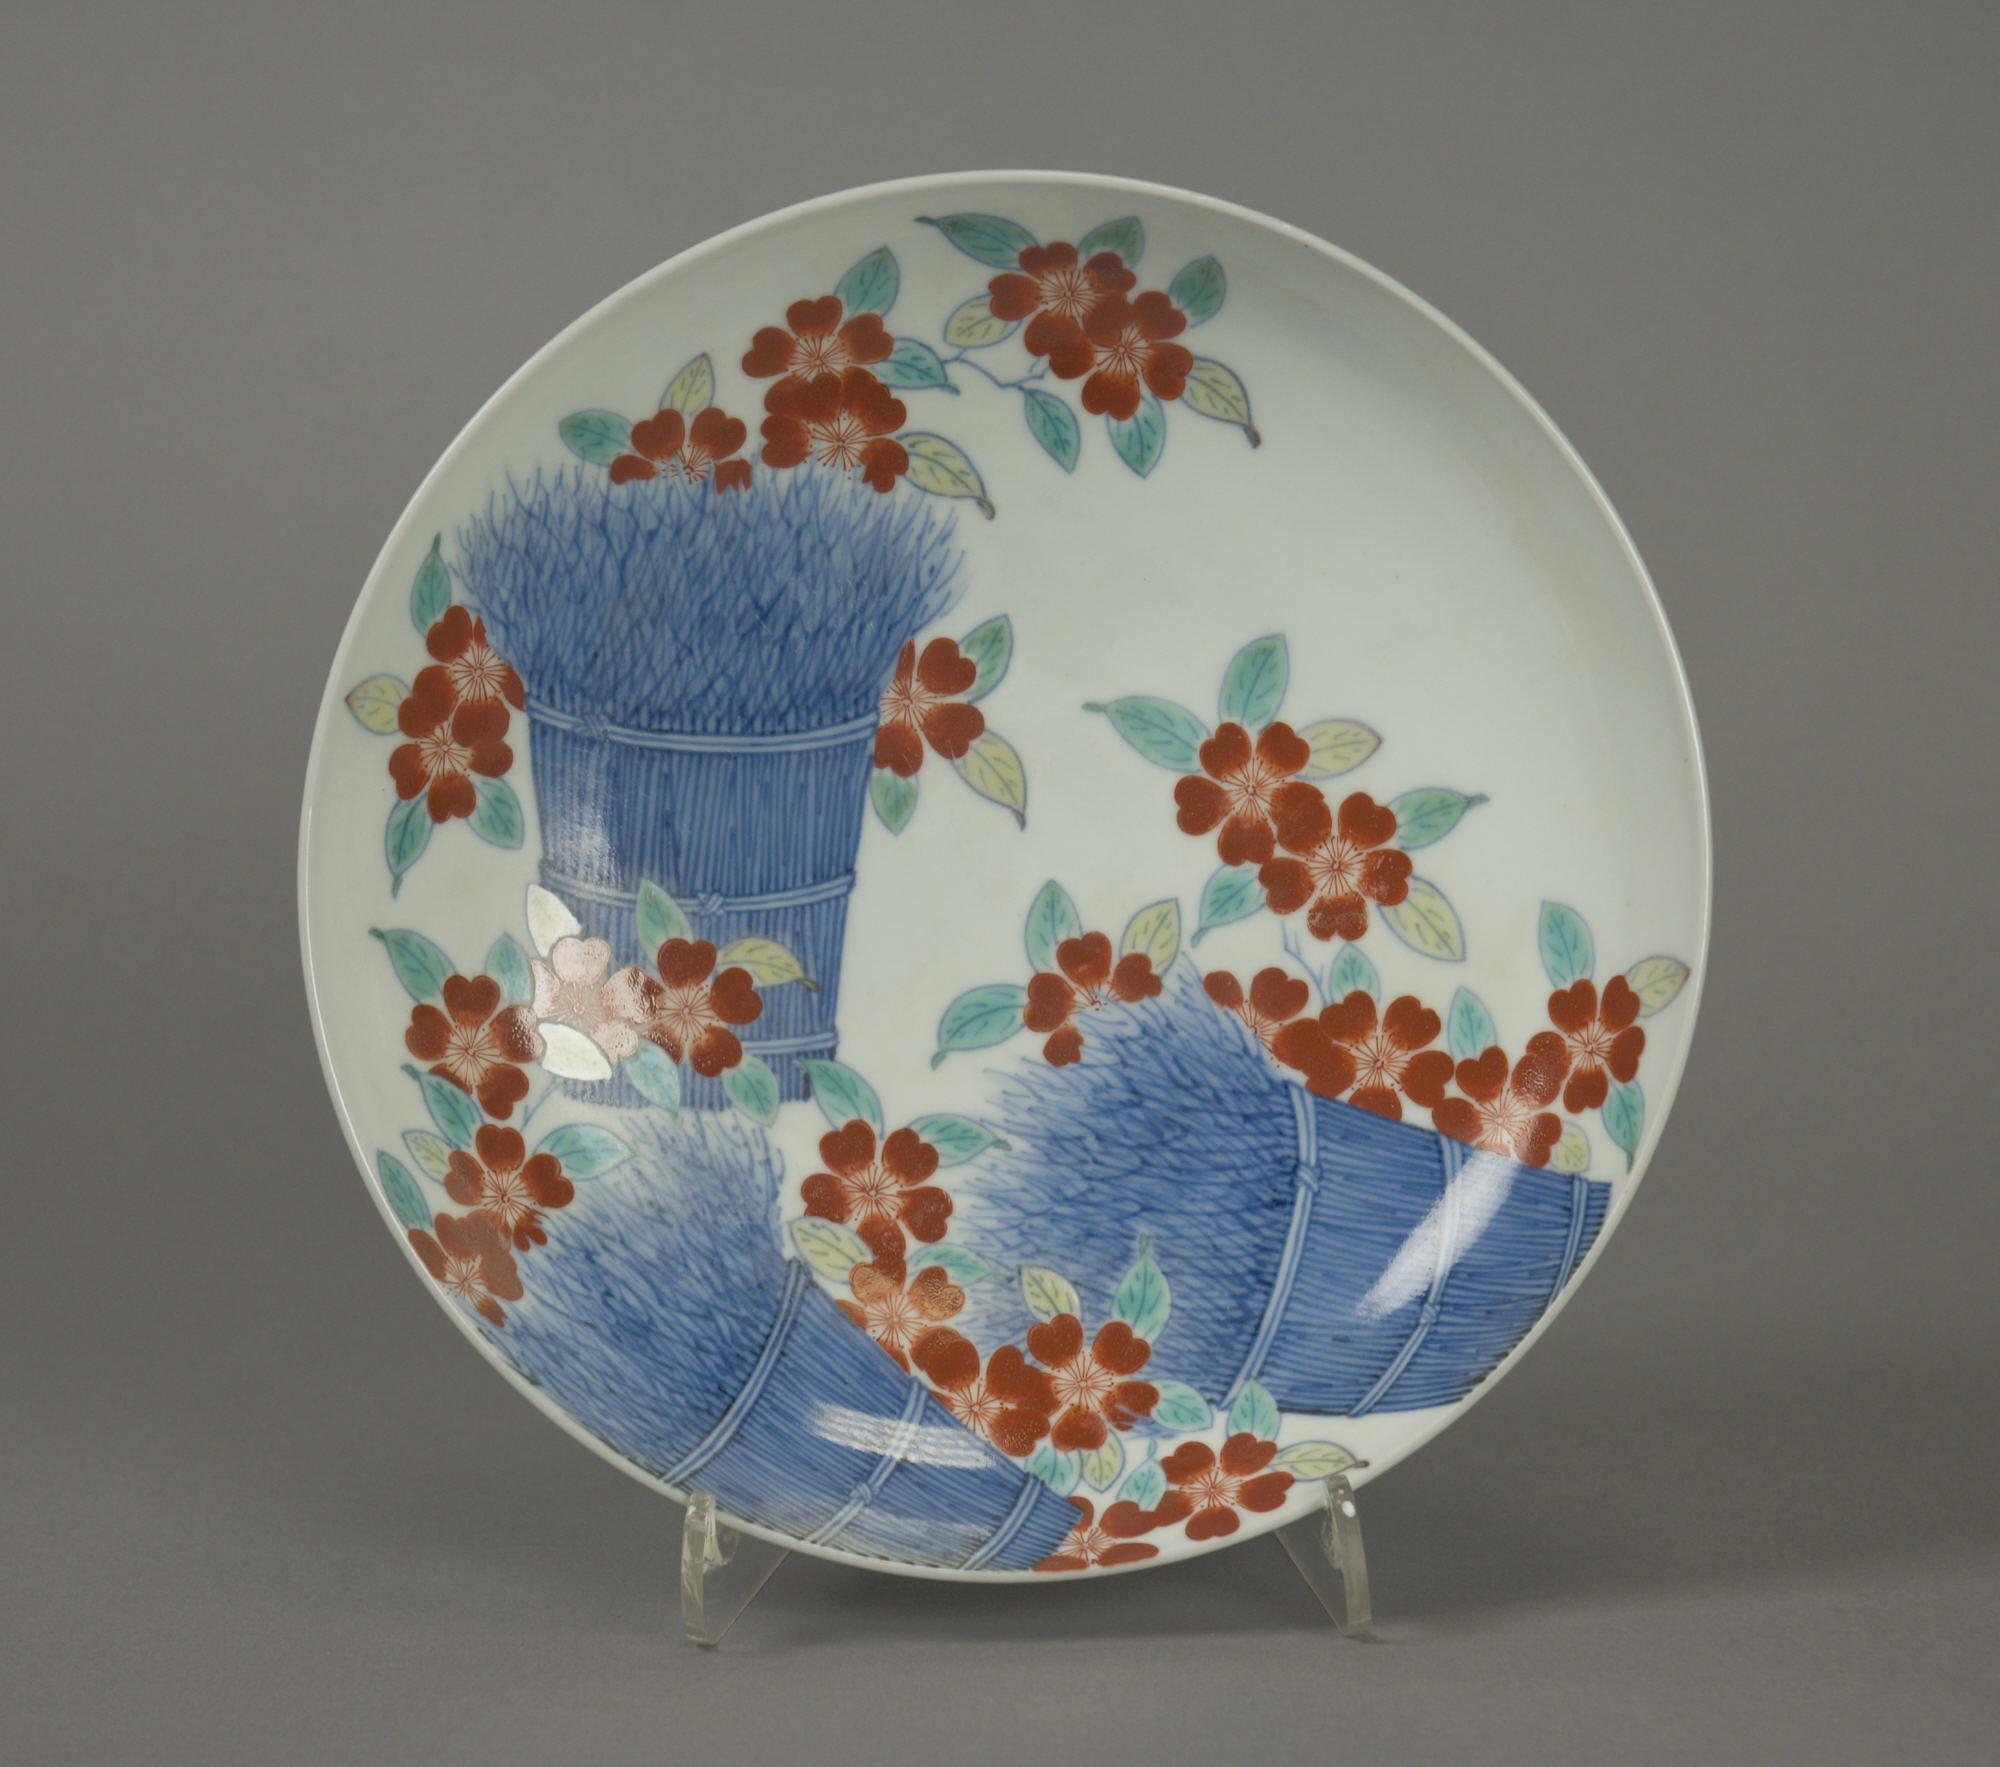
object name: plate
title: Dish with Cherry Blossoms and Bundles of Brushwood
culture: japanese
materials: enamel, porcelain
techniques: overglaze, polychrome, underglaze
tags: flowers,leaves